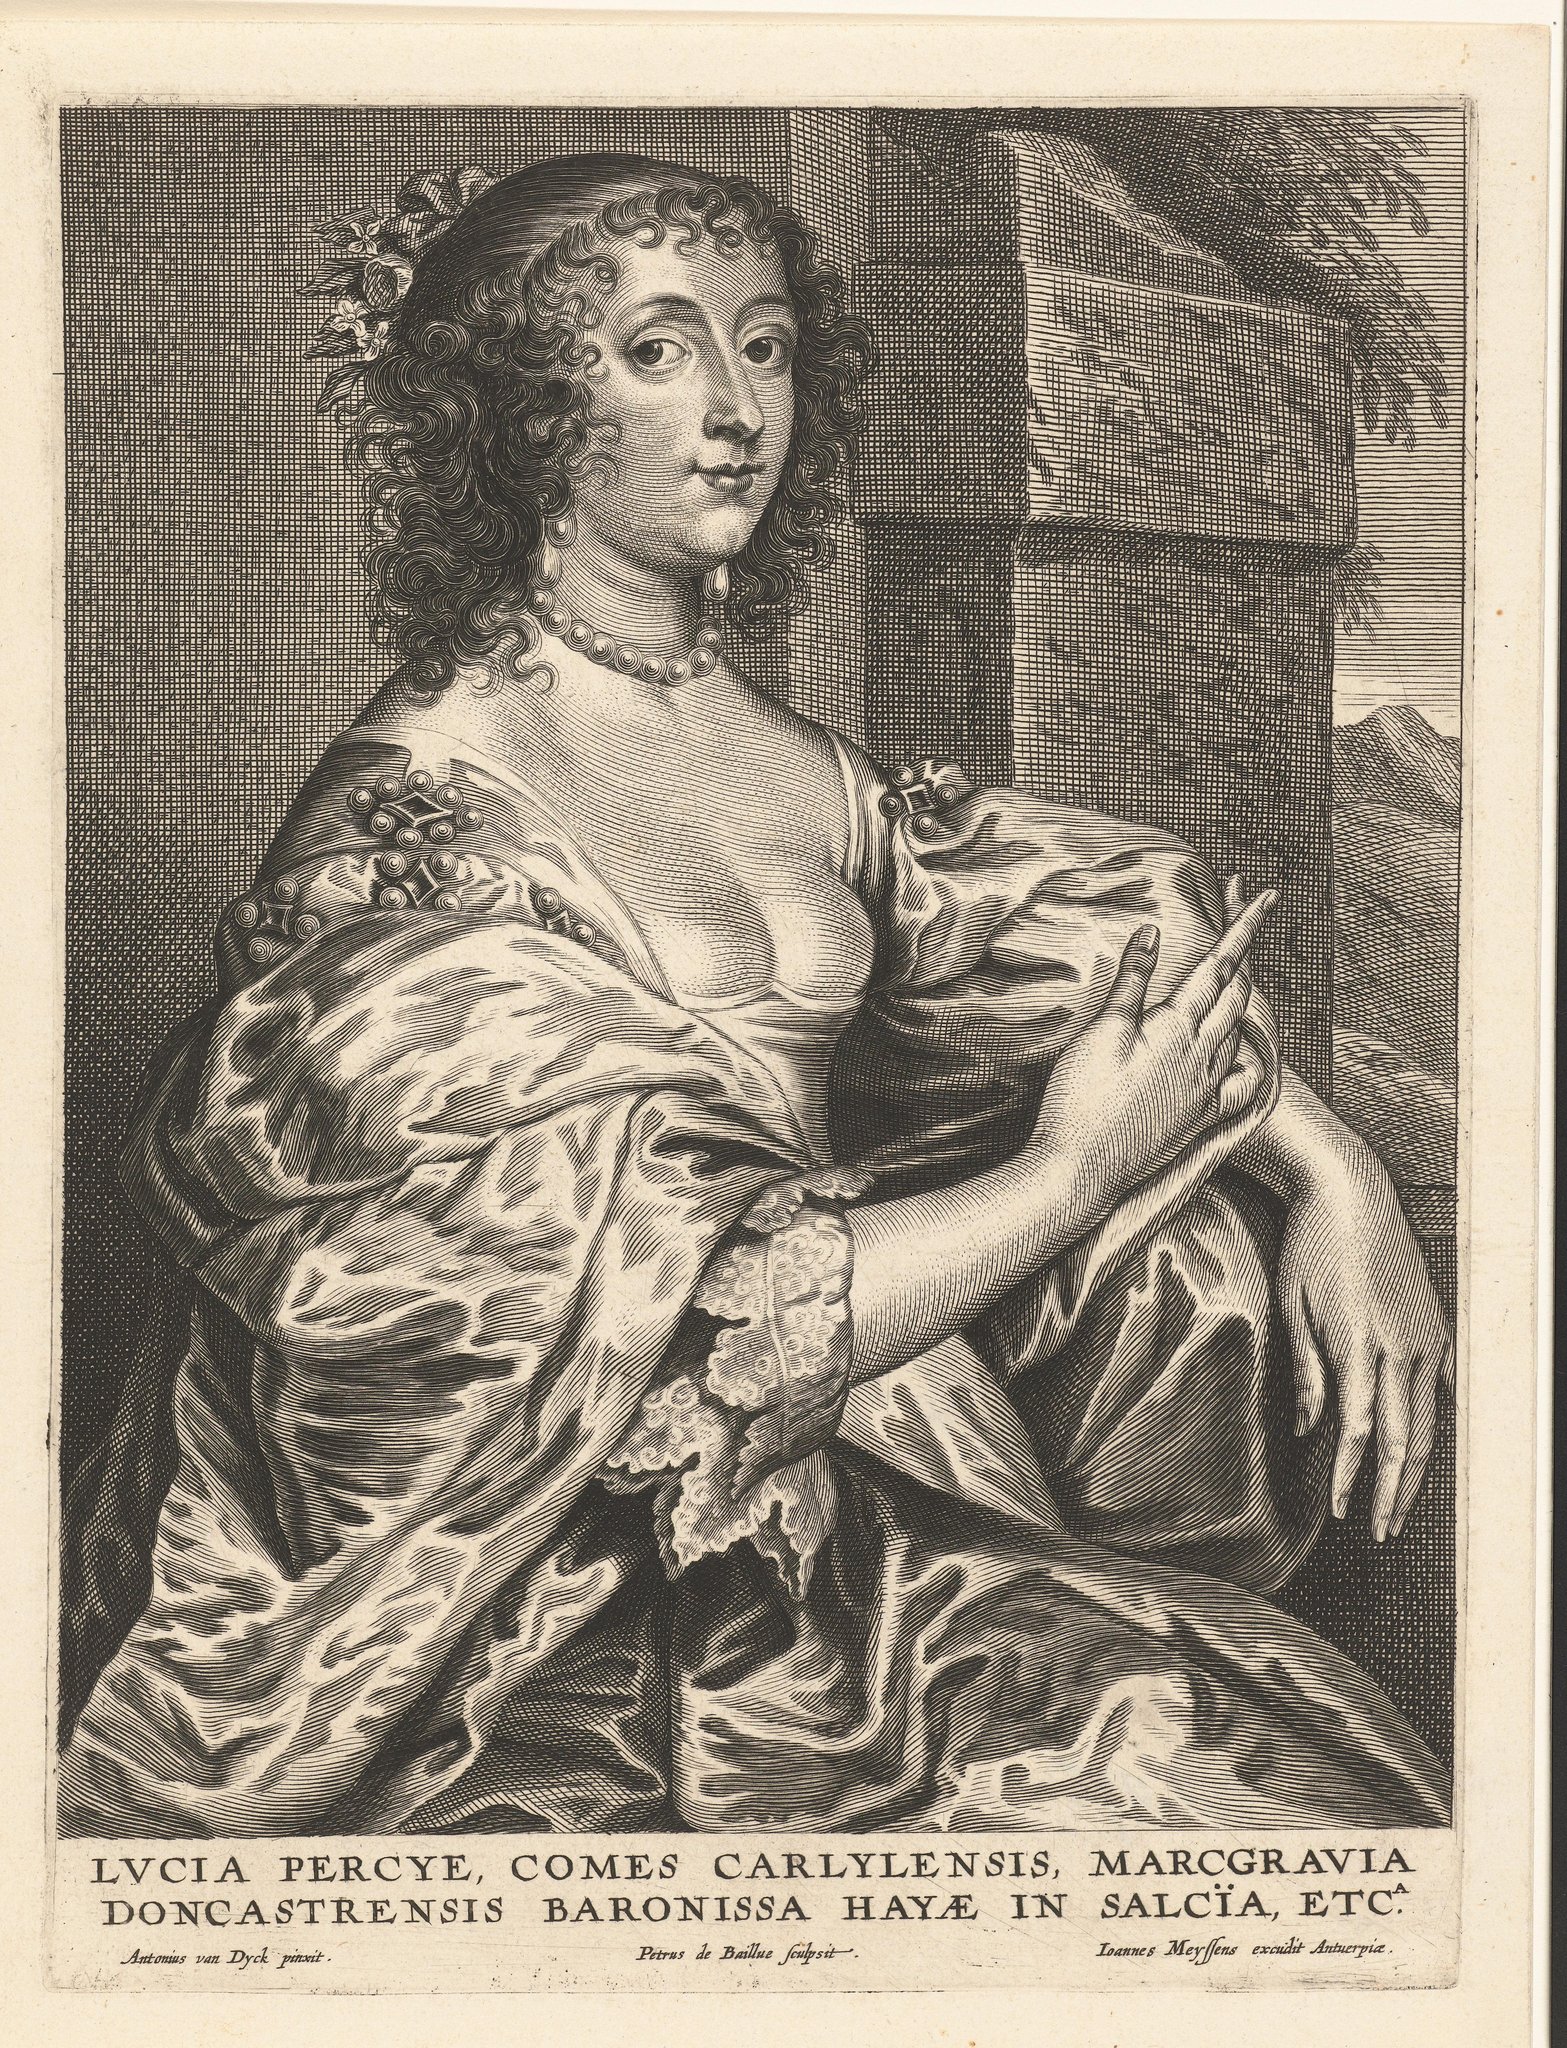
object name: print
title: Lvcia Percye, comes (...) in Salcïa, etc.a.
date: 1623-1660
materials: paper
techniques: engraving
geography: antwerp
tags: lucy percy (gravin van carlisle)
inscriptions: collector's mark: Lugt 240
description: Prent naar schilderij van Anthony van Dyck in de collectie van Petworth House, Sussex.